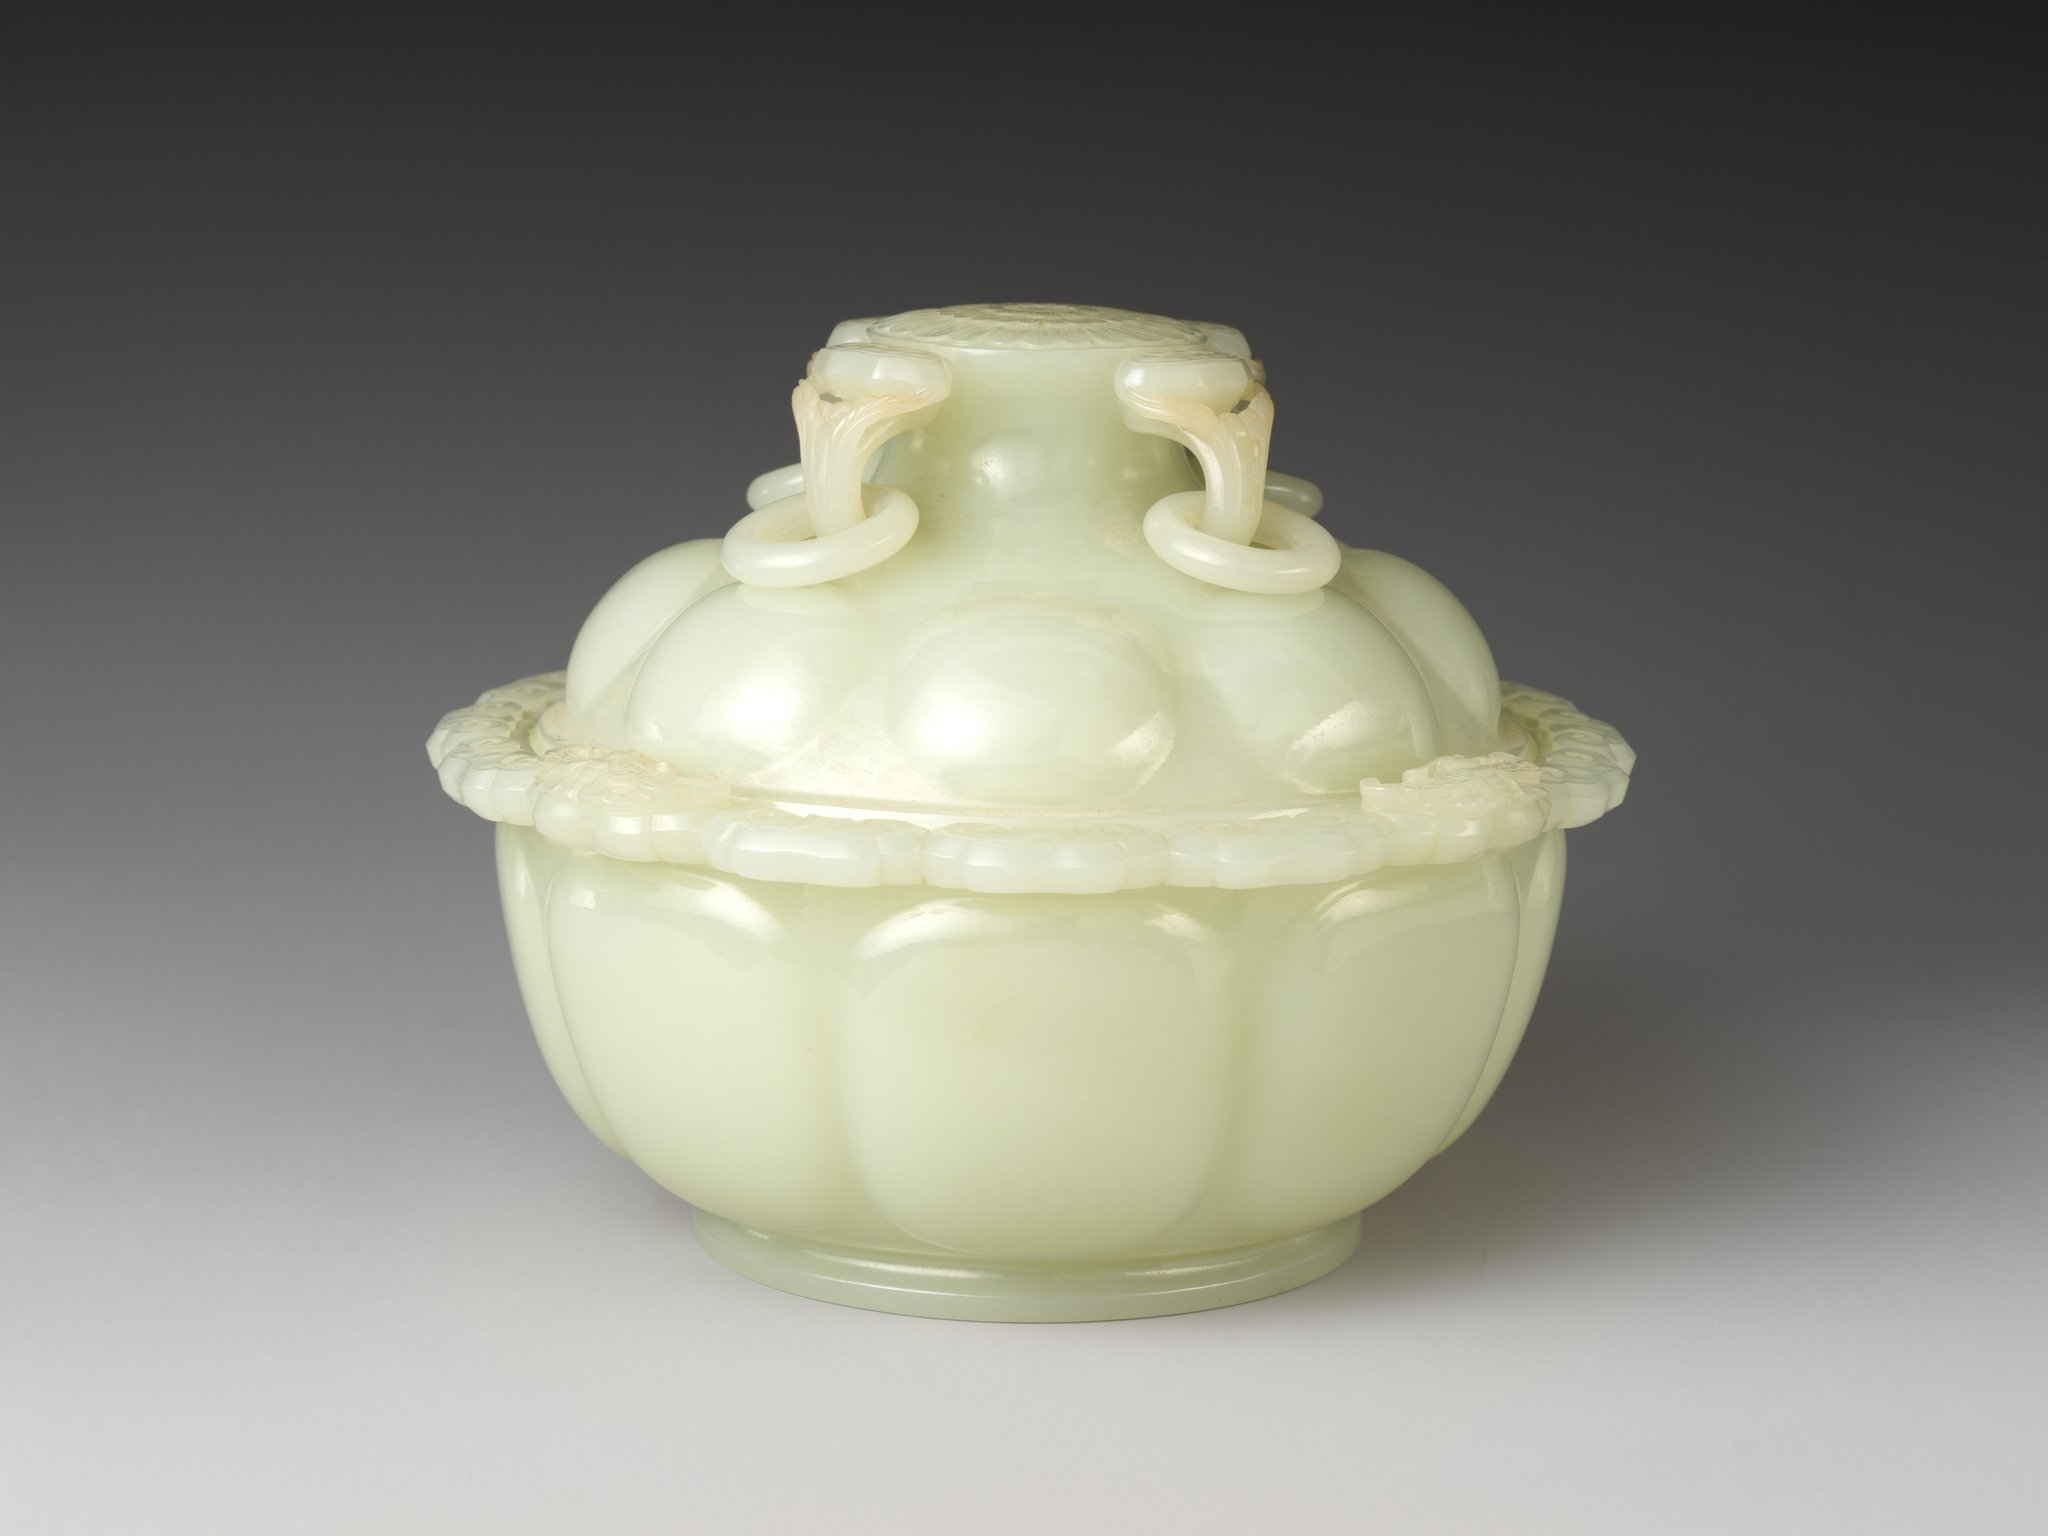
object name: bowl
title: Covered bowl with ring handles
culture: chinese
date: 1751-1800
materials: jade